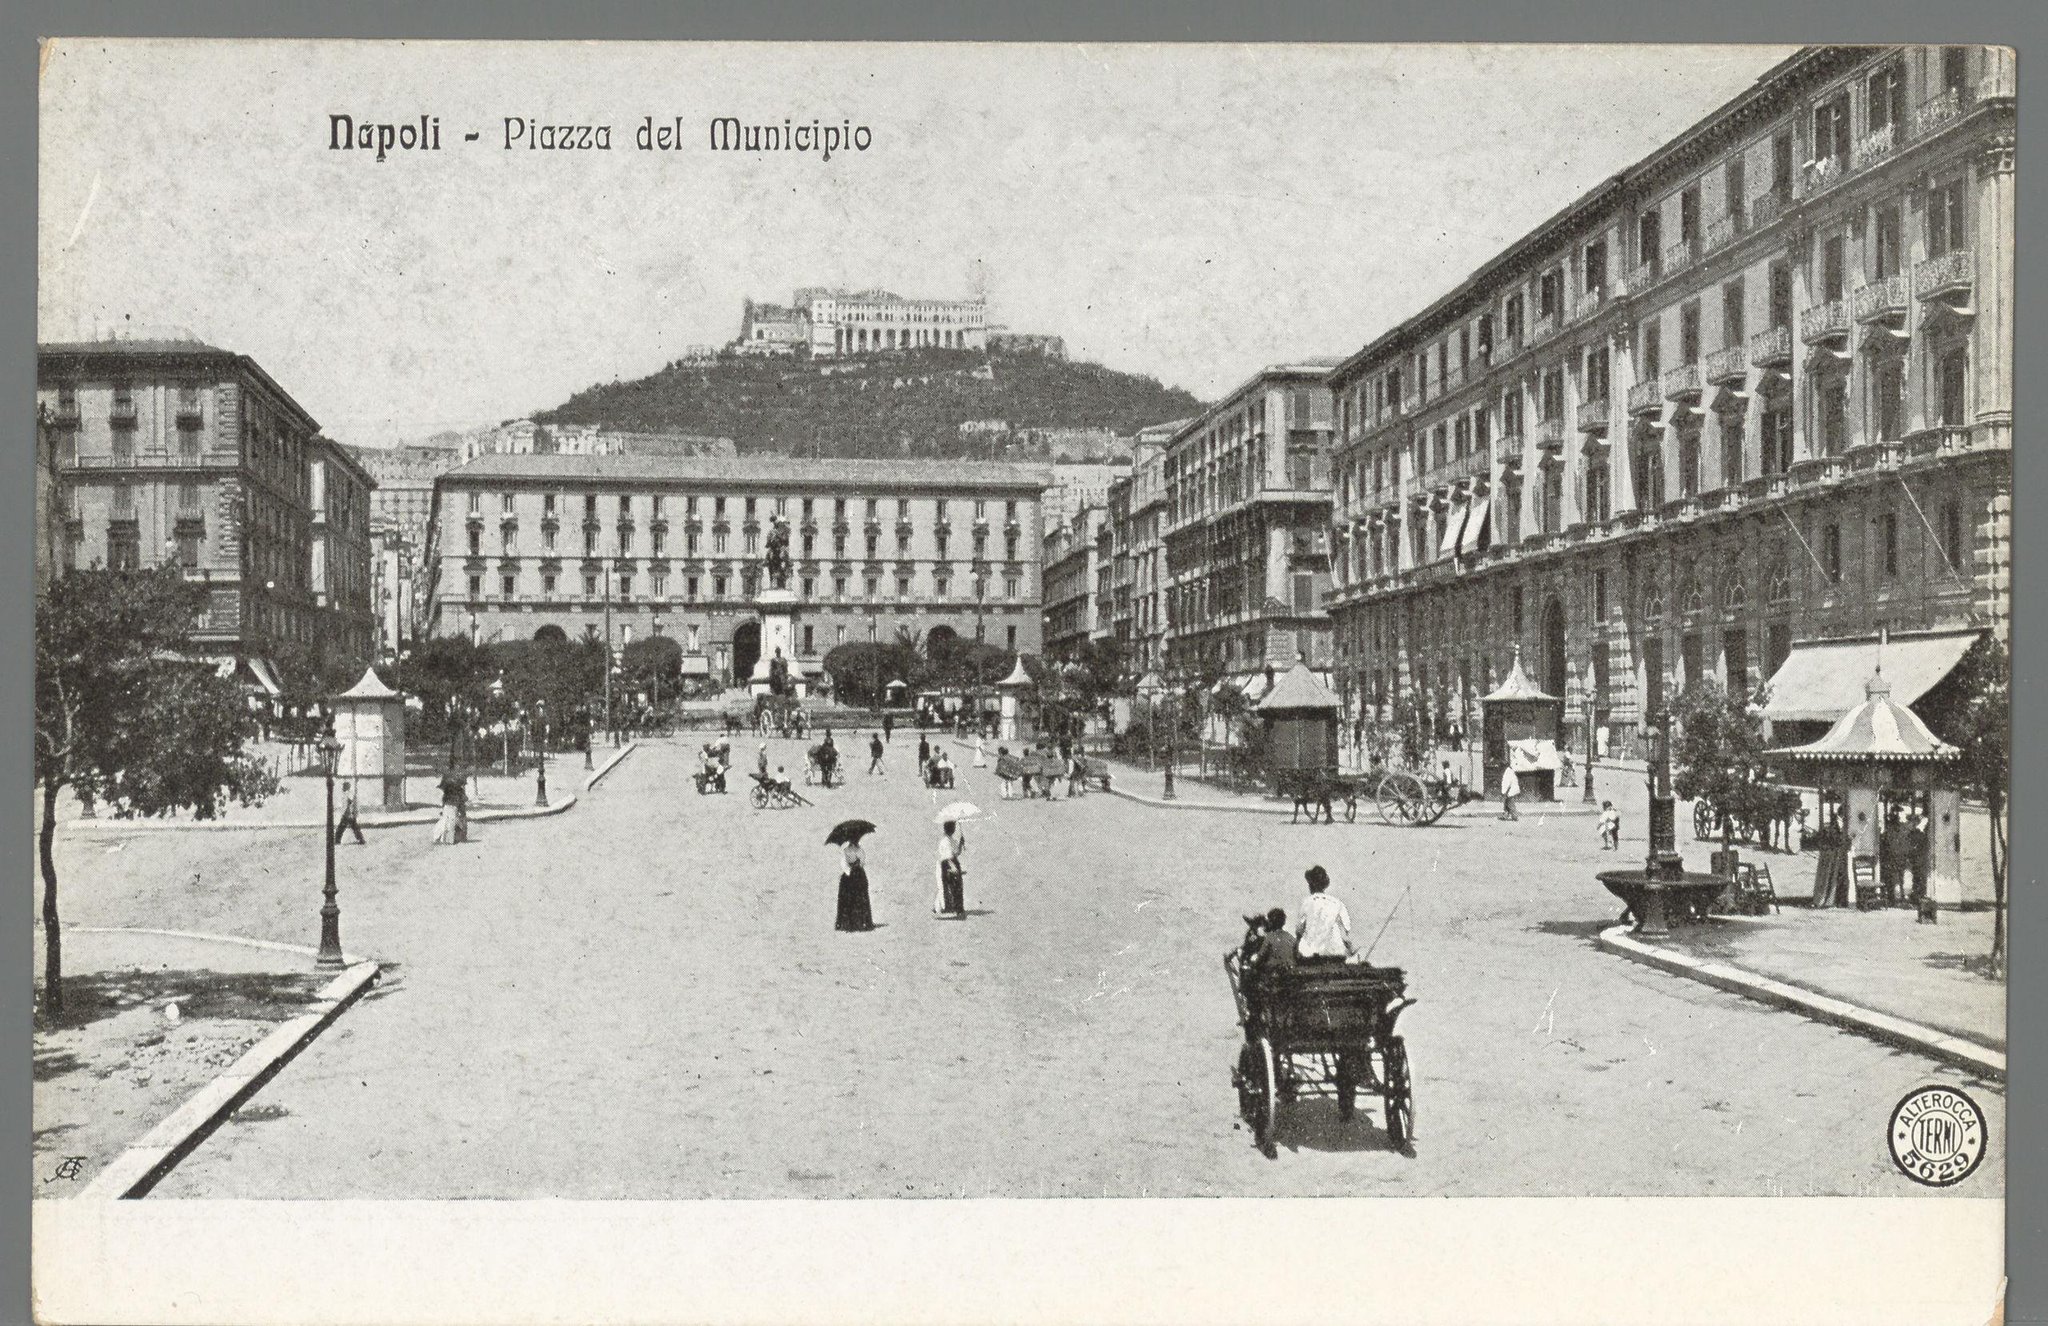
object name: photomechanical print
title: Napoli. Piazza del Municipio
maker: Anonymous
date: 1906-1910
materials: cardboard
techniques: autotype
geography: terni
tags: (high) hill, square, place, circus, etc. (+ city(-scape) with figures, staffage), naples